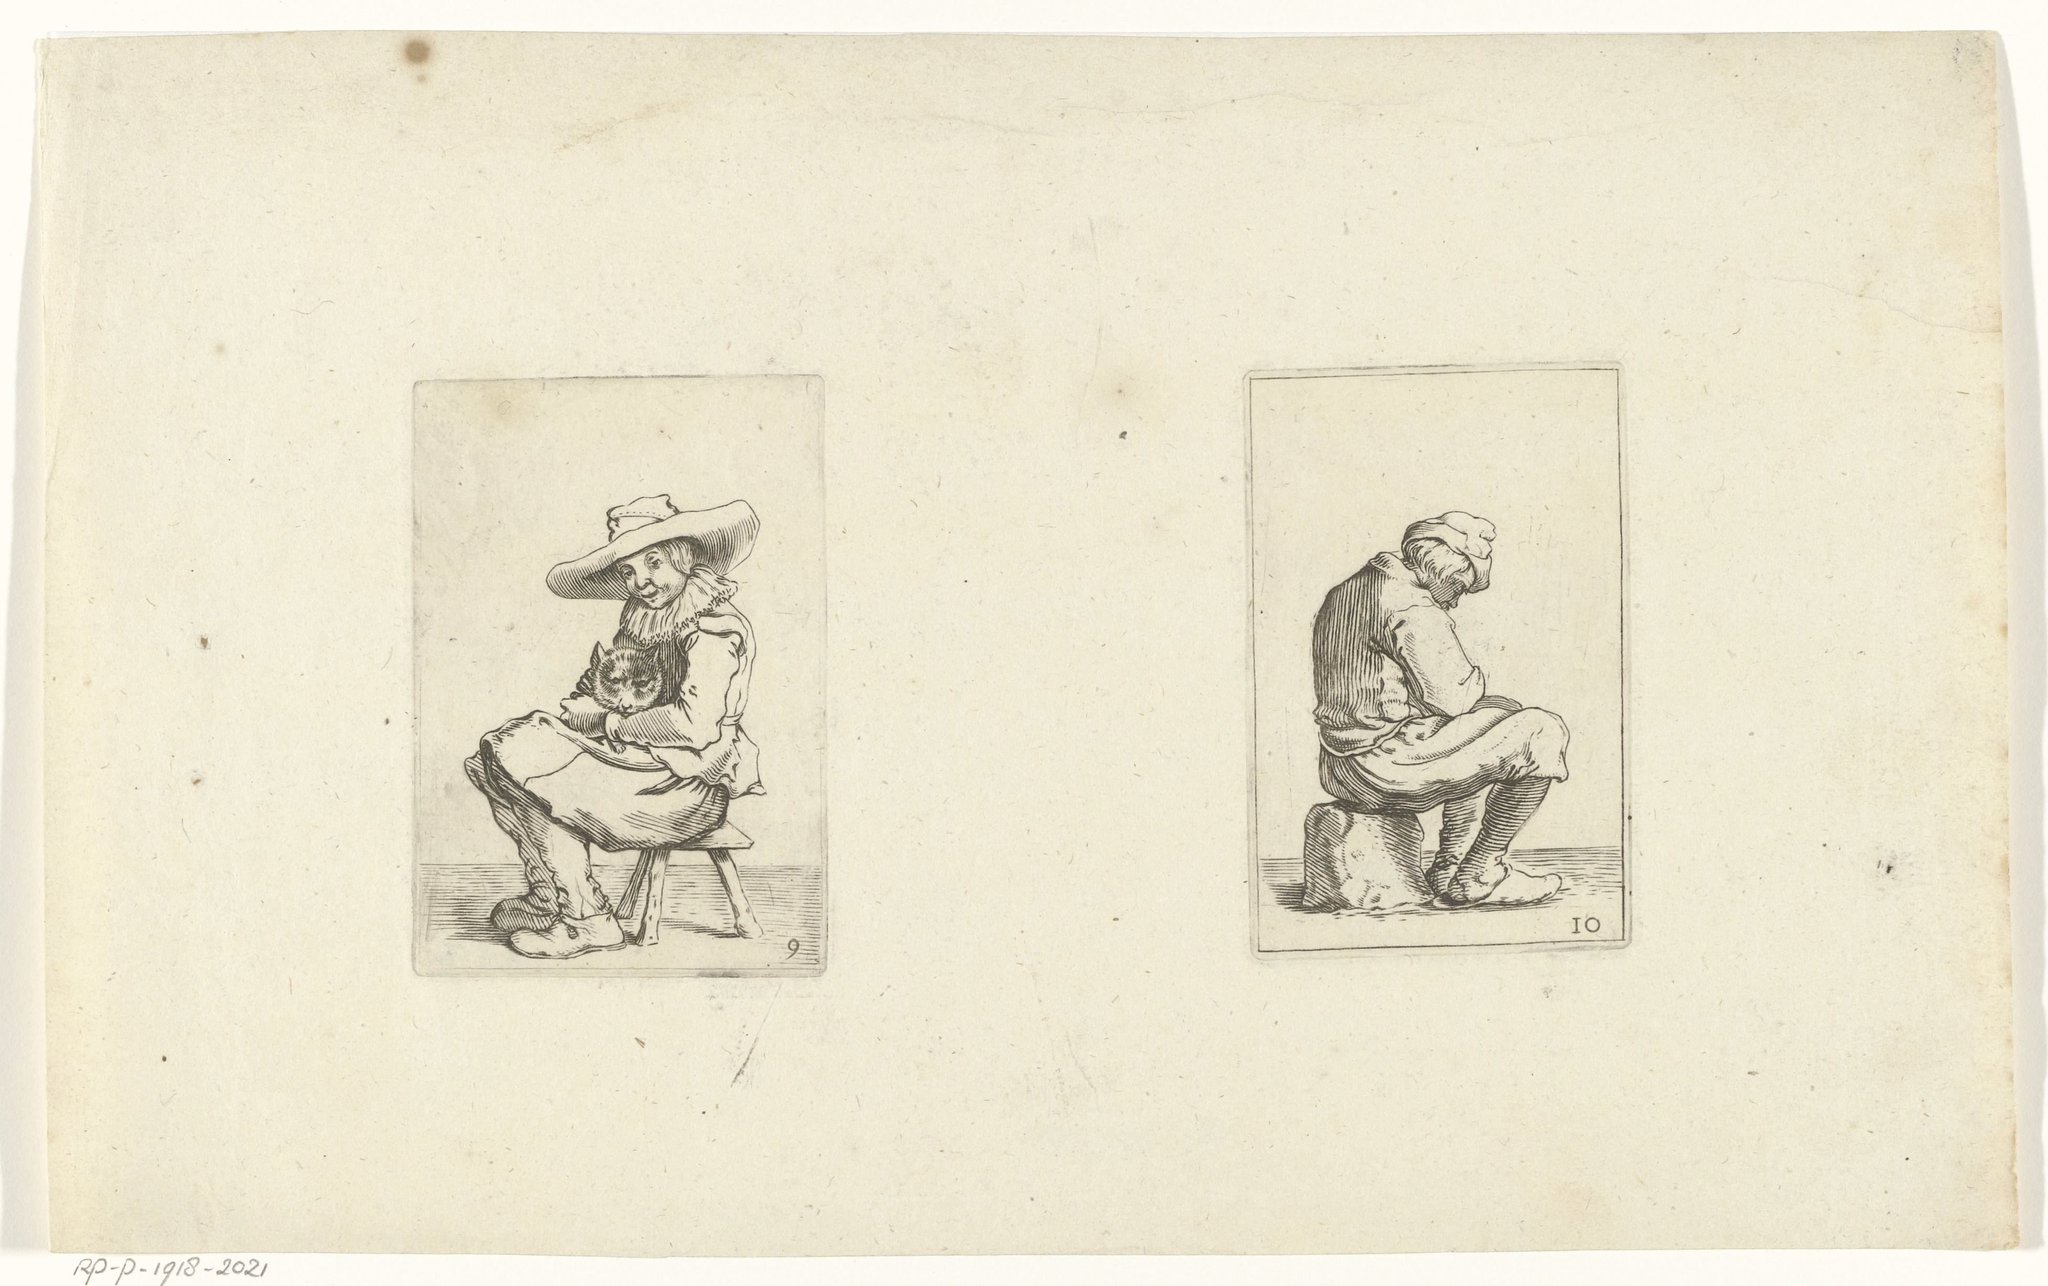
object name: print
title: Zittende figuren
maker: Anonymous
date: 1650-1700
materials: paper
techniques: engraving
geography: netherlands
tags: sitting figure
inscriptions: collector's mark: Lugt 2233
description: Twee zittende figuren. Links een jongen met een kat op schoot gezeten op een kruk. Rechts een zittende en naar beneden kijkende figuur.